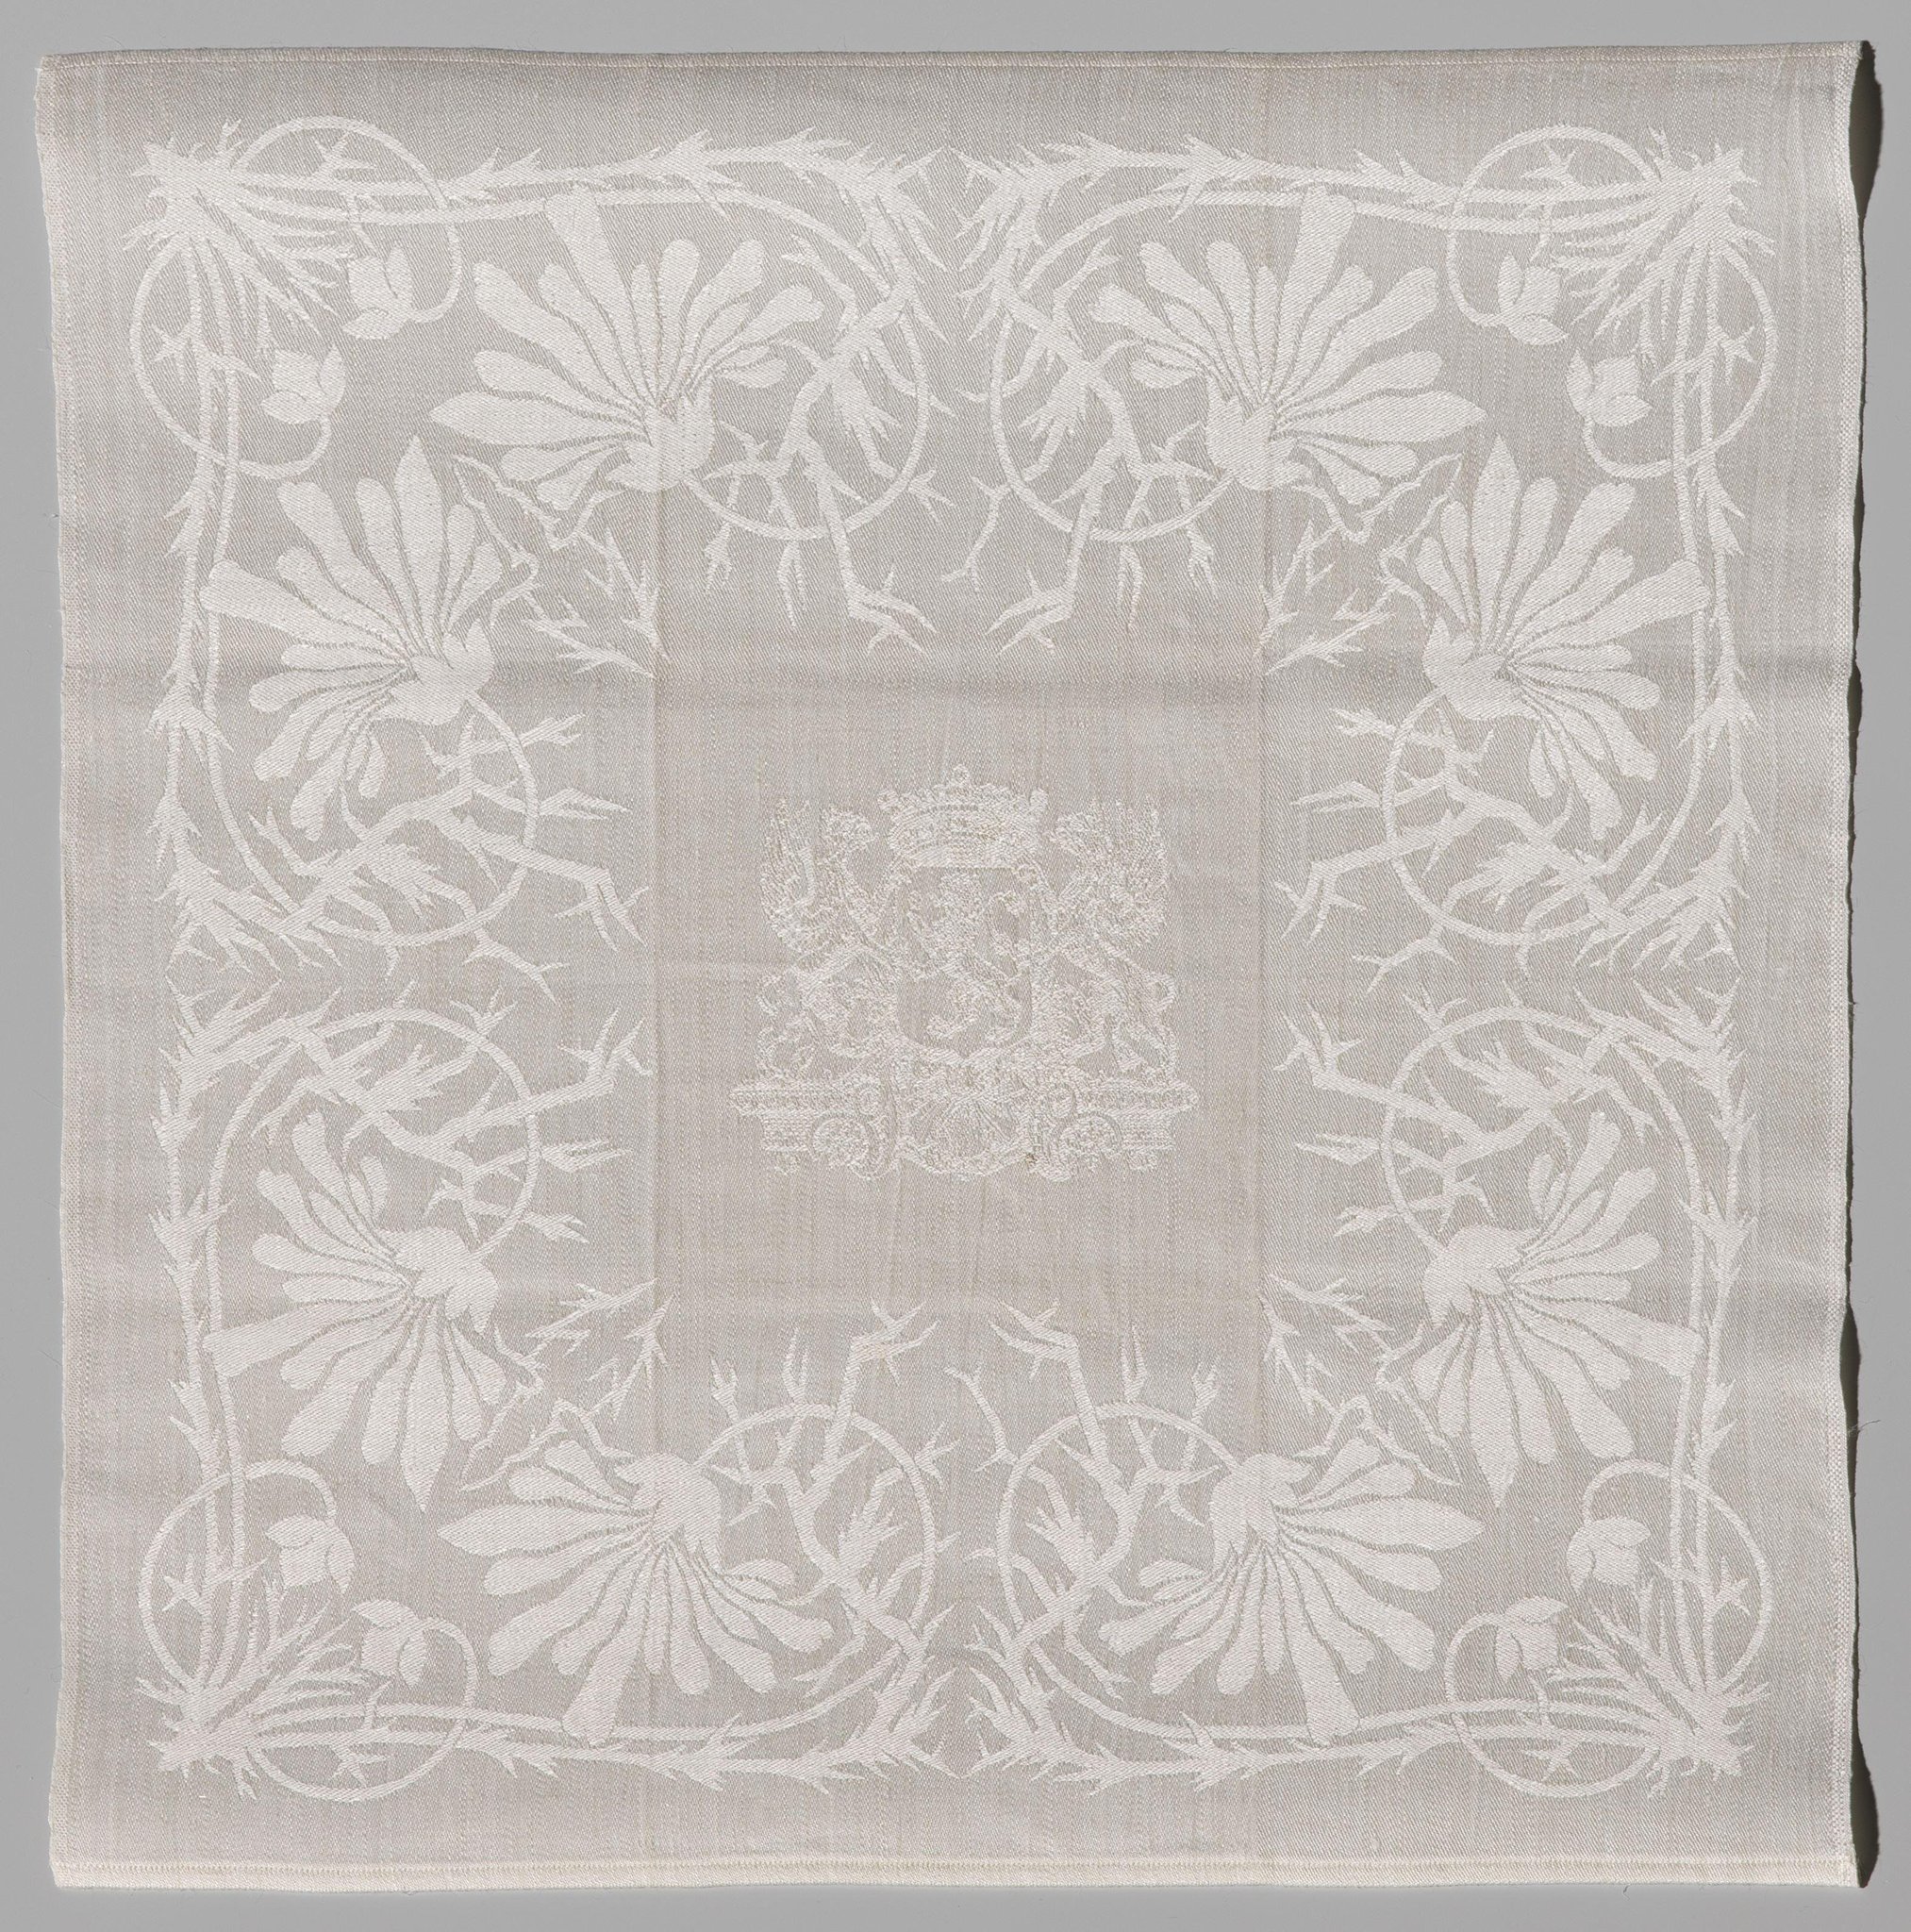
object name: vingerdoek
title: Vingerdoek van linnendamast met marguérite-dessin en in het midden een gekroond wapen met een leeuw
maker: cornelis van der sluys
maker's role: print maker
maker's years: 1881-1944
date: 1891-1944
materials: linen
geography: eindhoven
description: Vingerdoek van linnendamast met marguérite-dessin en in het midden een gekroond wapen met een leeuw.